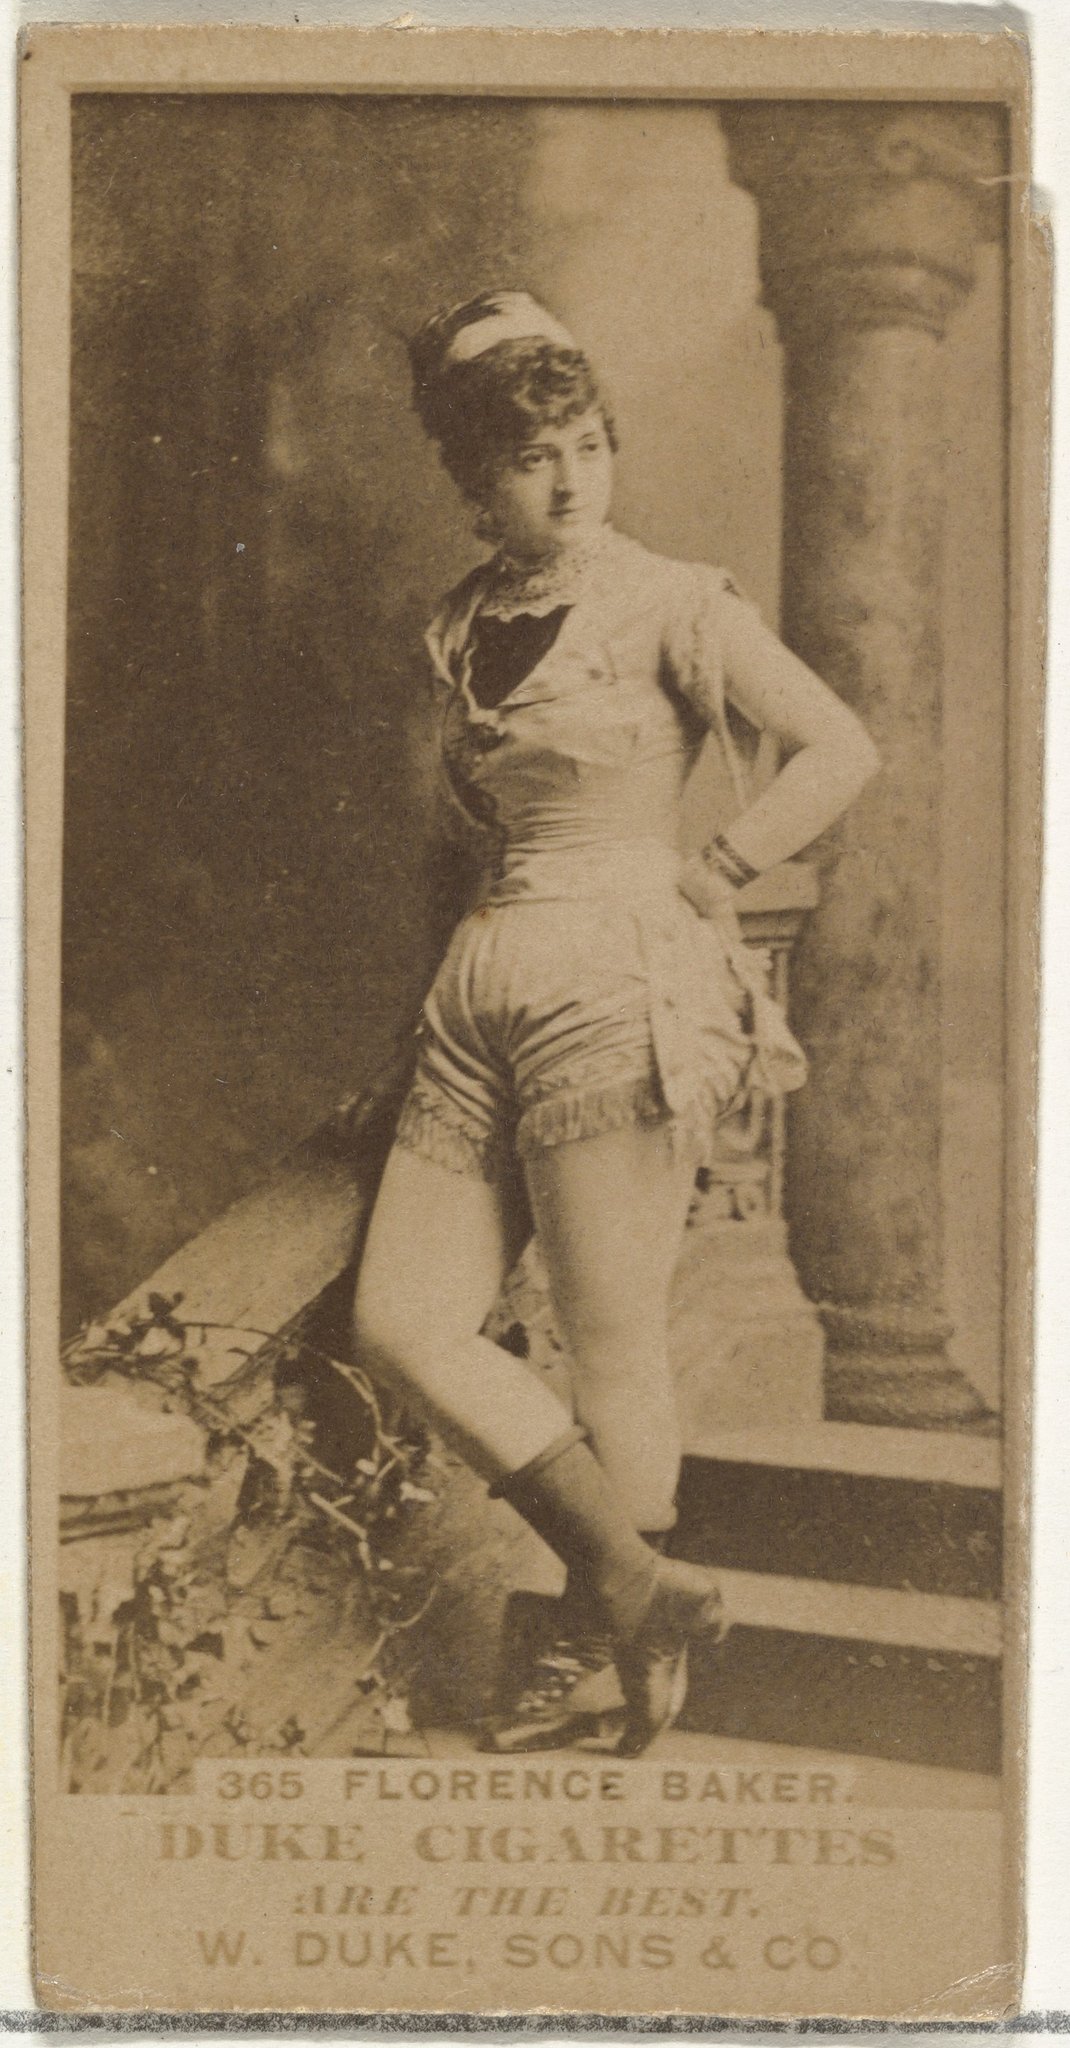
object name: photograph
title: Card Number 365, Florence Baker, from the Actors and Actresses series (N145-7) issued by Duke Sons & Co. to promote Duke Cigarettes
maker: w. duke, sons & co.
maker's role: publisher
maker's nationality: american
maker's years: 1870-1920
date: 1880-1889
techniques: albumen silver print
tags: portraits,women,actresses